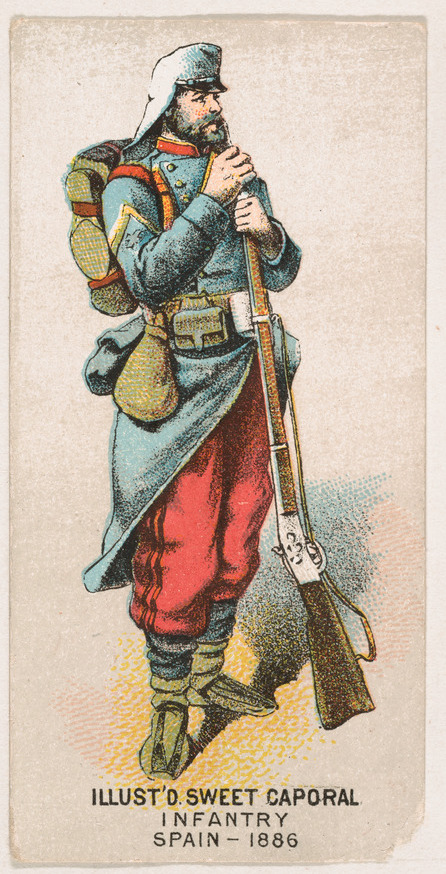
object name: print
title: Infantry, Spain, 1886, from the Military Series (N224) issued by Kinney Tobacco Company to promote Sweet Caporal Cigarettes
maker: kinney brothers tobacco company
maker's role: publisher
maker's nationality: american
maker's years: 1869-2011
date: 1888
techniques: color lithograph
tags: military,firearms,men